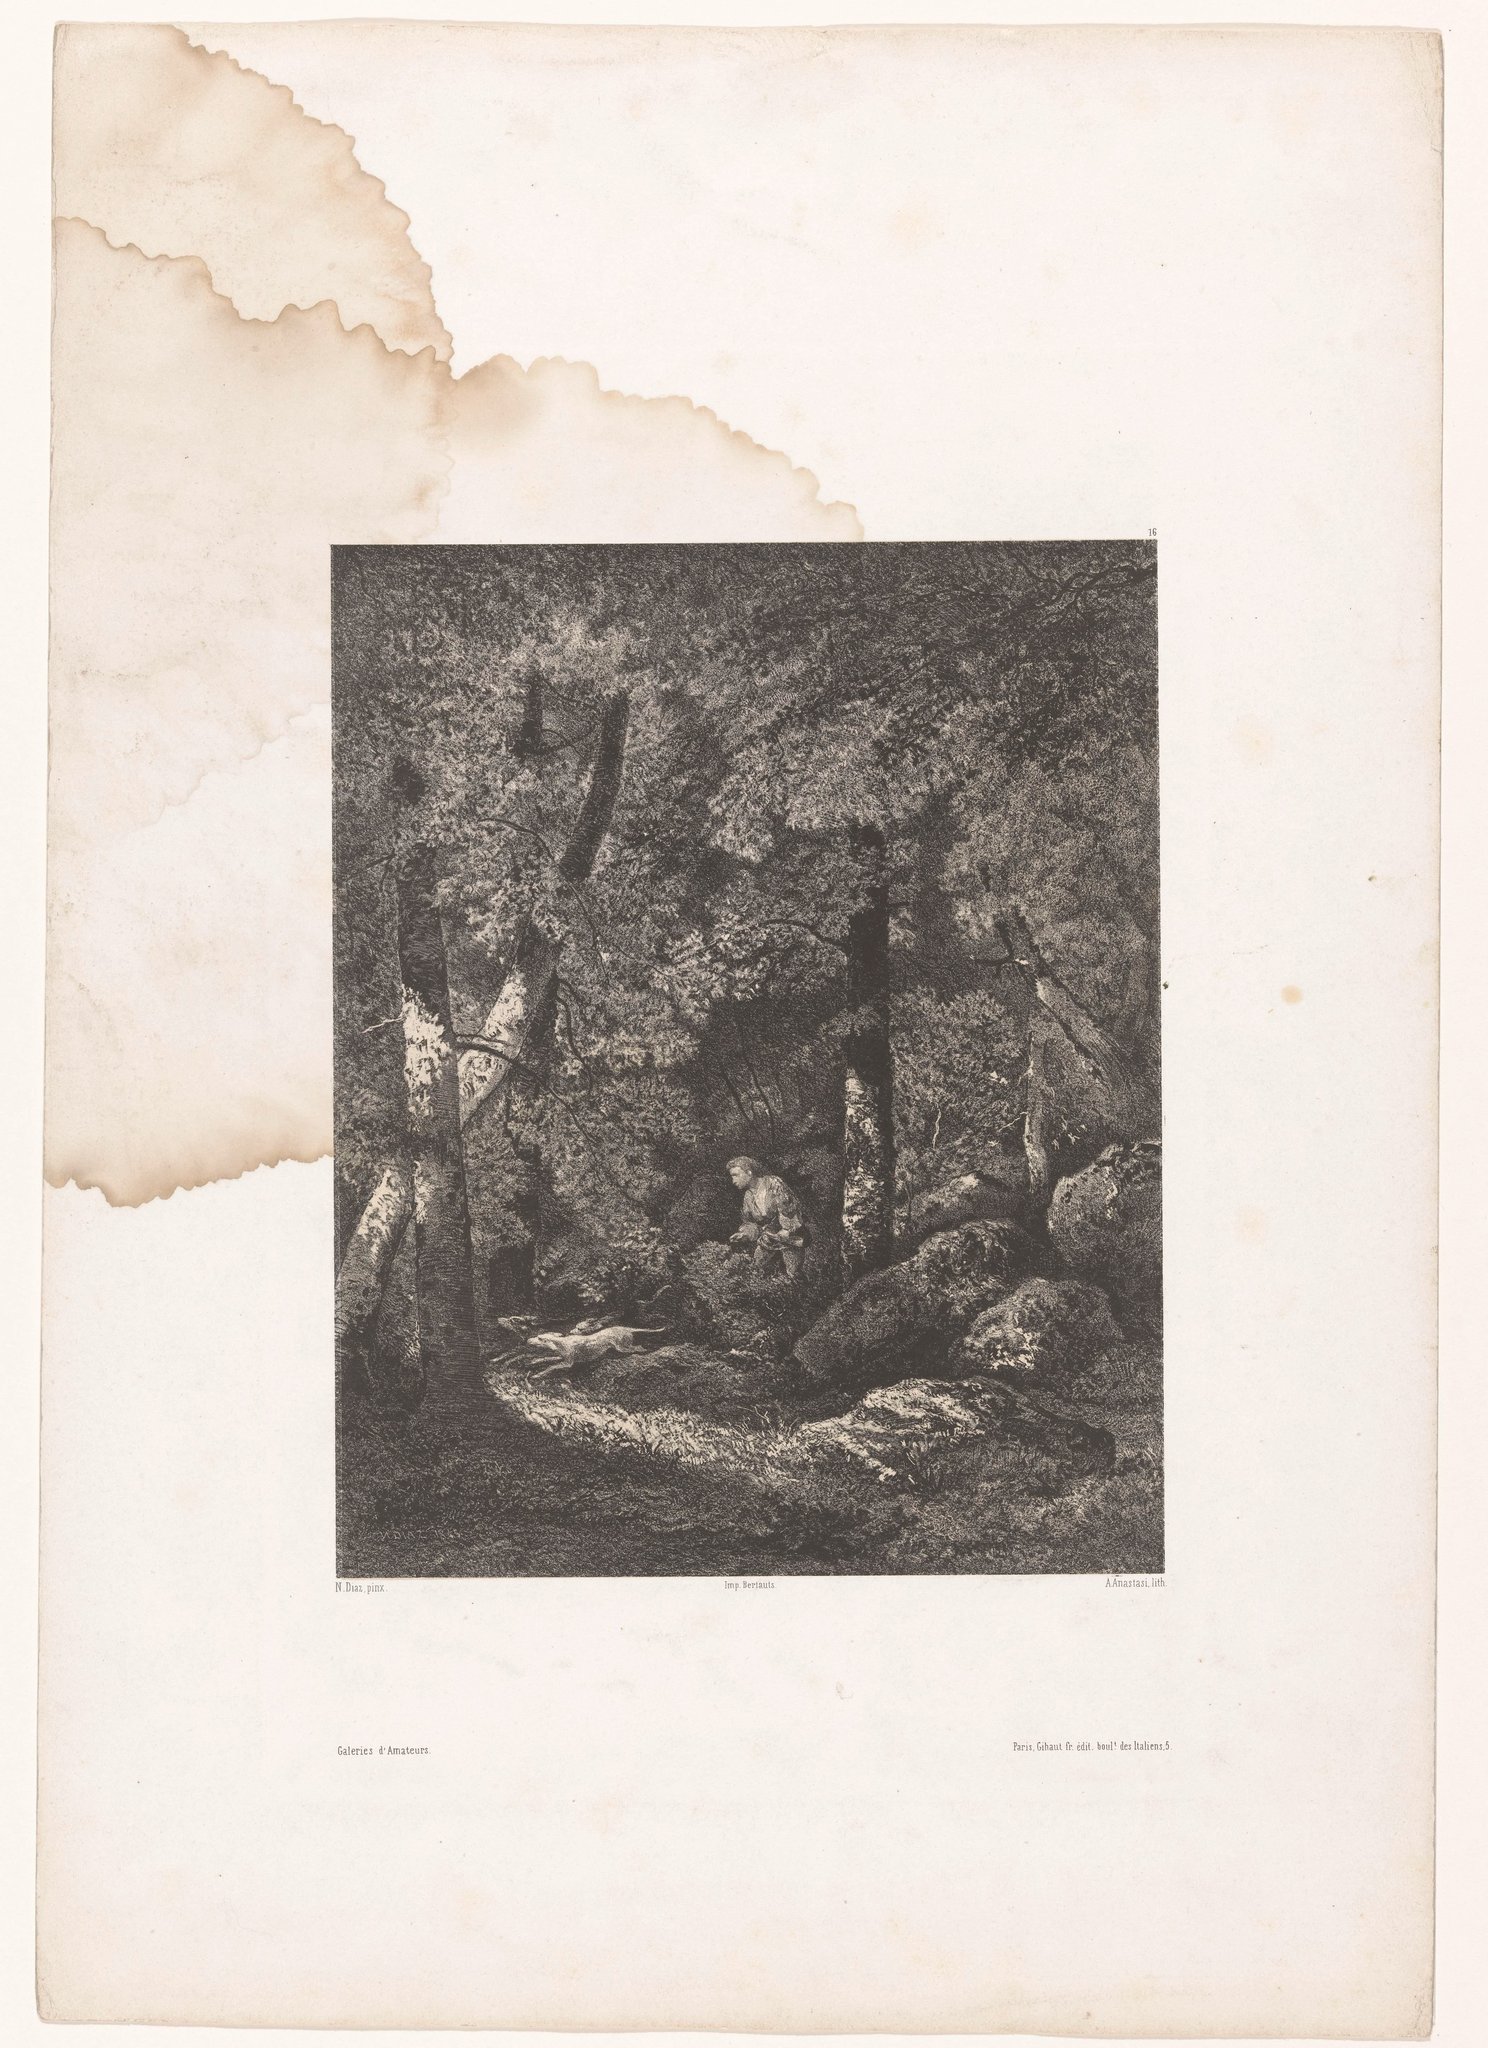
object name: print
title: Afbeeldingen naar Franse landschapsschilders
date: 1848-1853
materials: paper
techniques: tone lithography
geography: paris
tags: hunting, chase, forest, wood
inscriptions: collector's mark: Lugt 2228